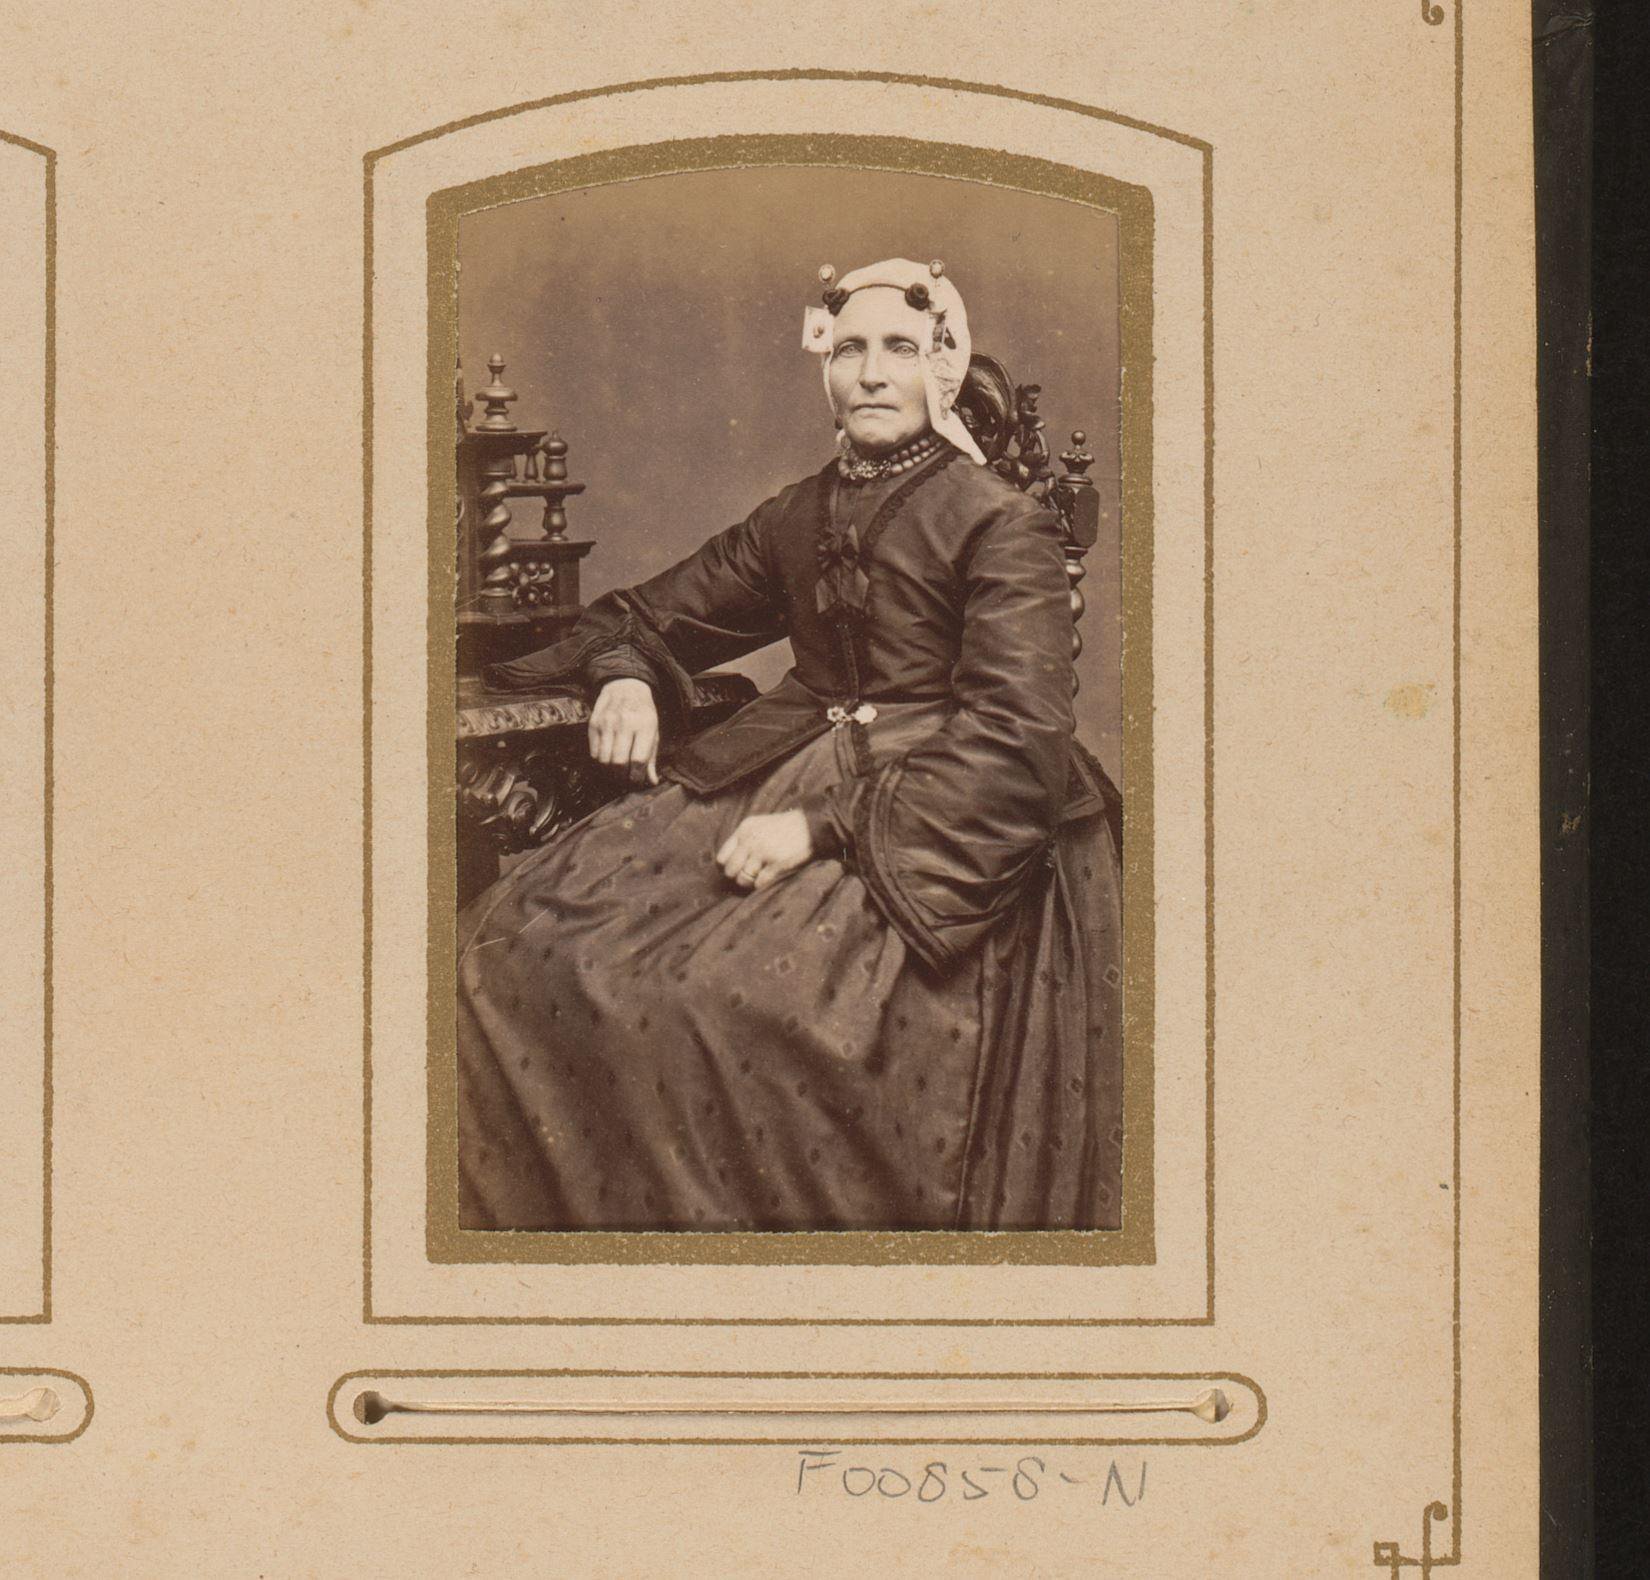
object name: album leaf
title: Portret van een zittende vrouw met muts, gelijkend op Friese kap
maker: pieter vlaanderen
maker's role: fotograaf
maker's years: 1840-1878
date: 1867-1878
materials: cardboard, photographic support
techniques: albumen print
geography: alkmaar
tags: historical persons - bb - woman, head-gear: cap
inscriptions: inscription: ‘Alkmaar, Verdronken Oord, Wyk D 34’